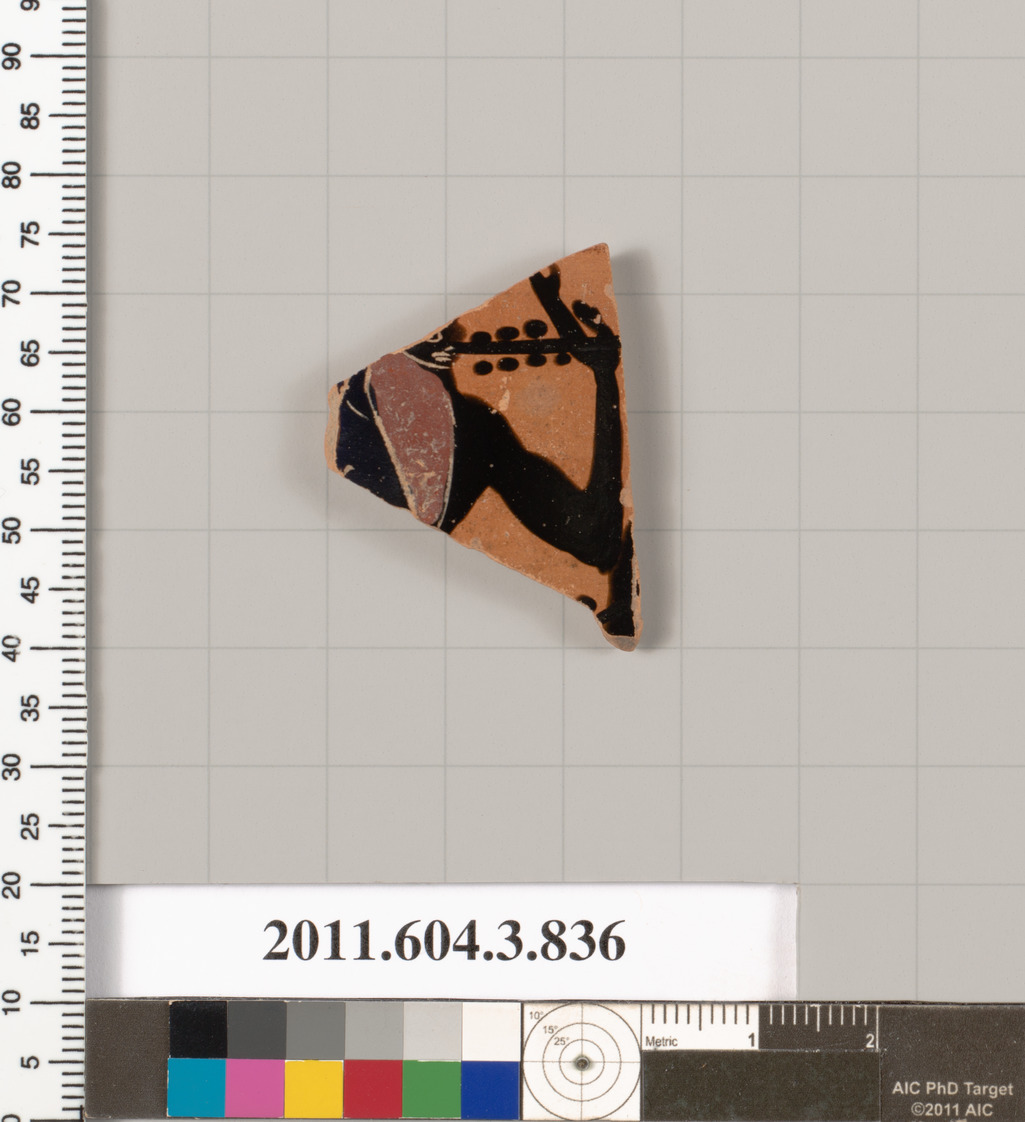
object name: lekythos fragment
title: Terracotta fragment of a lekythos (oil flask)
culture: greek, attic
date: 534-501 BCE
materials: terracotta